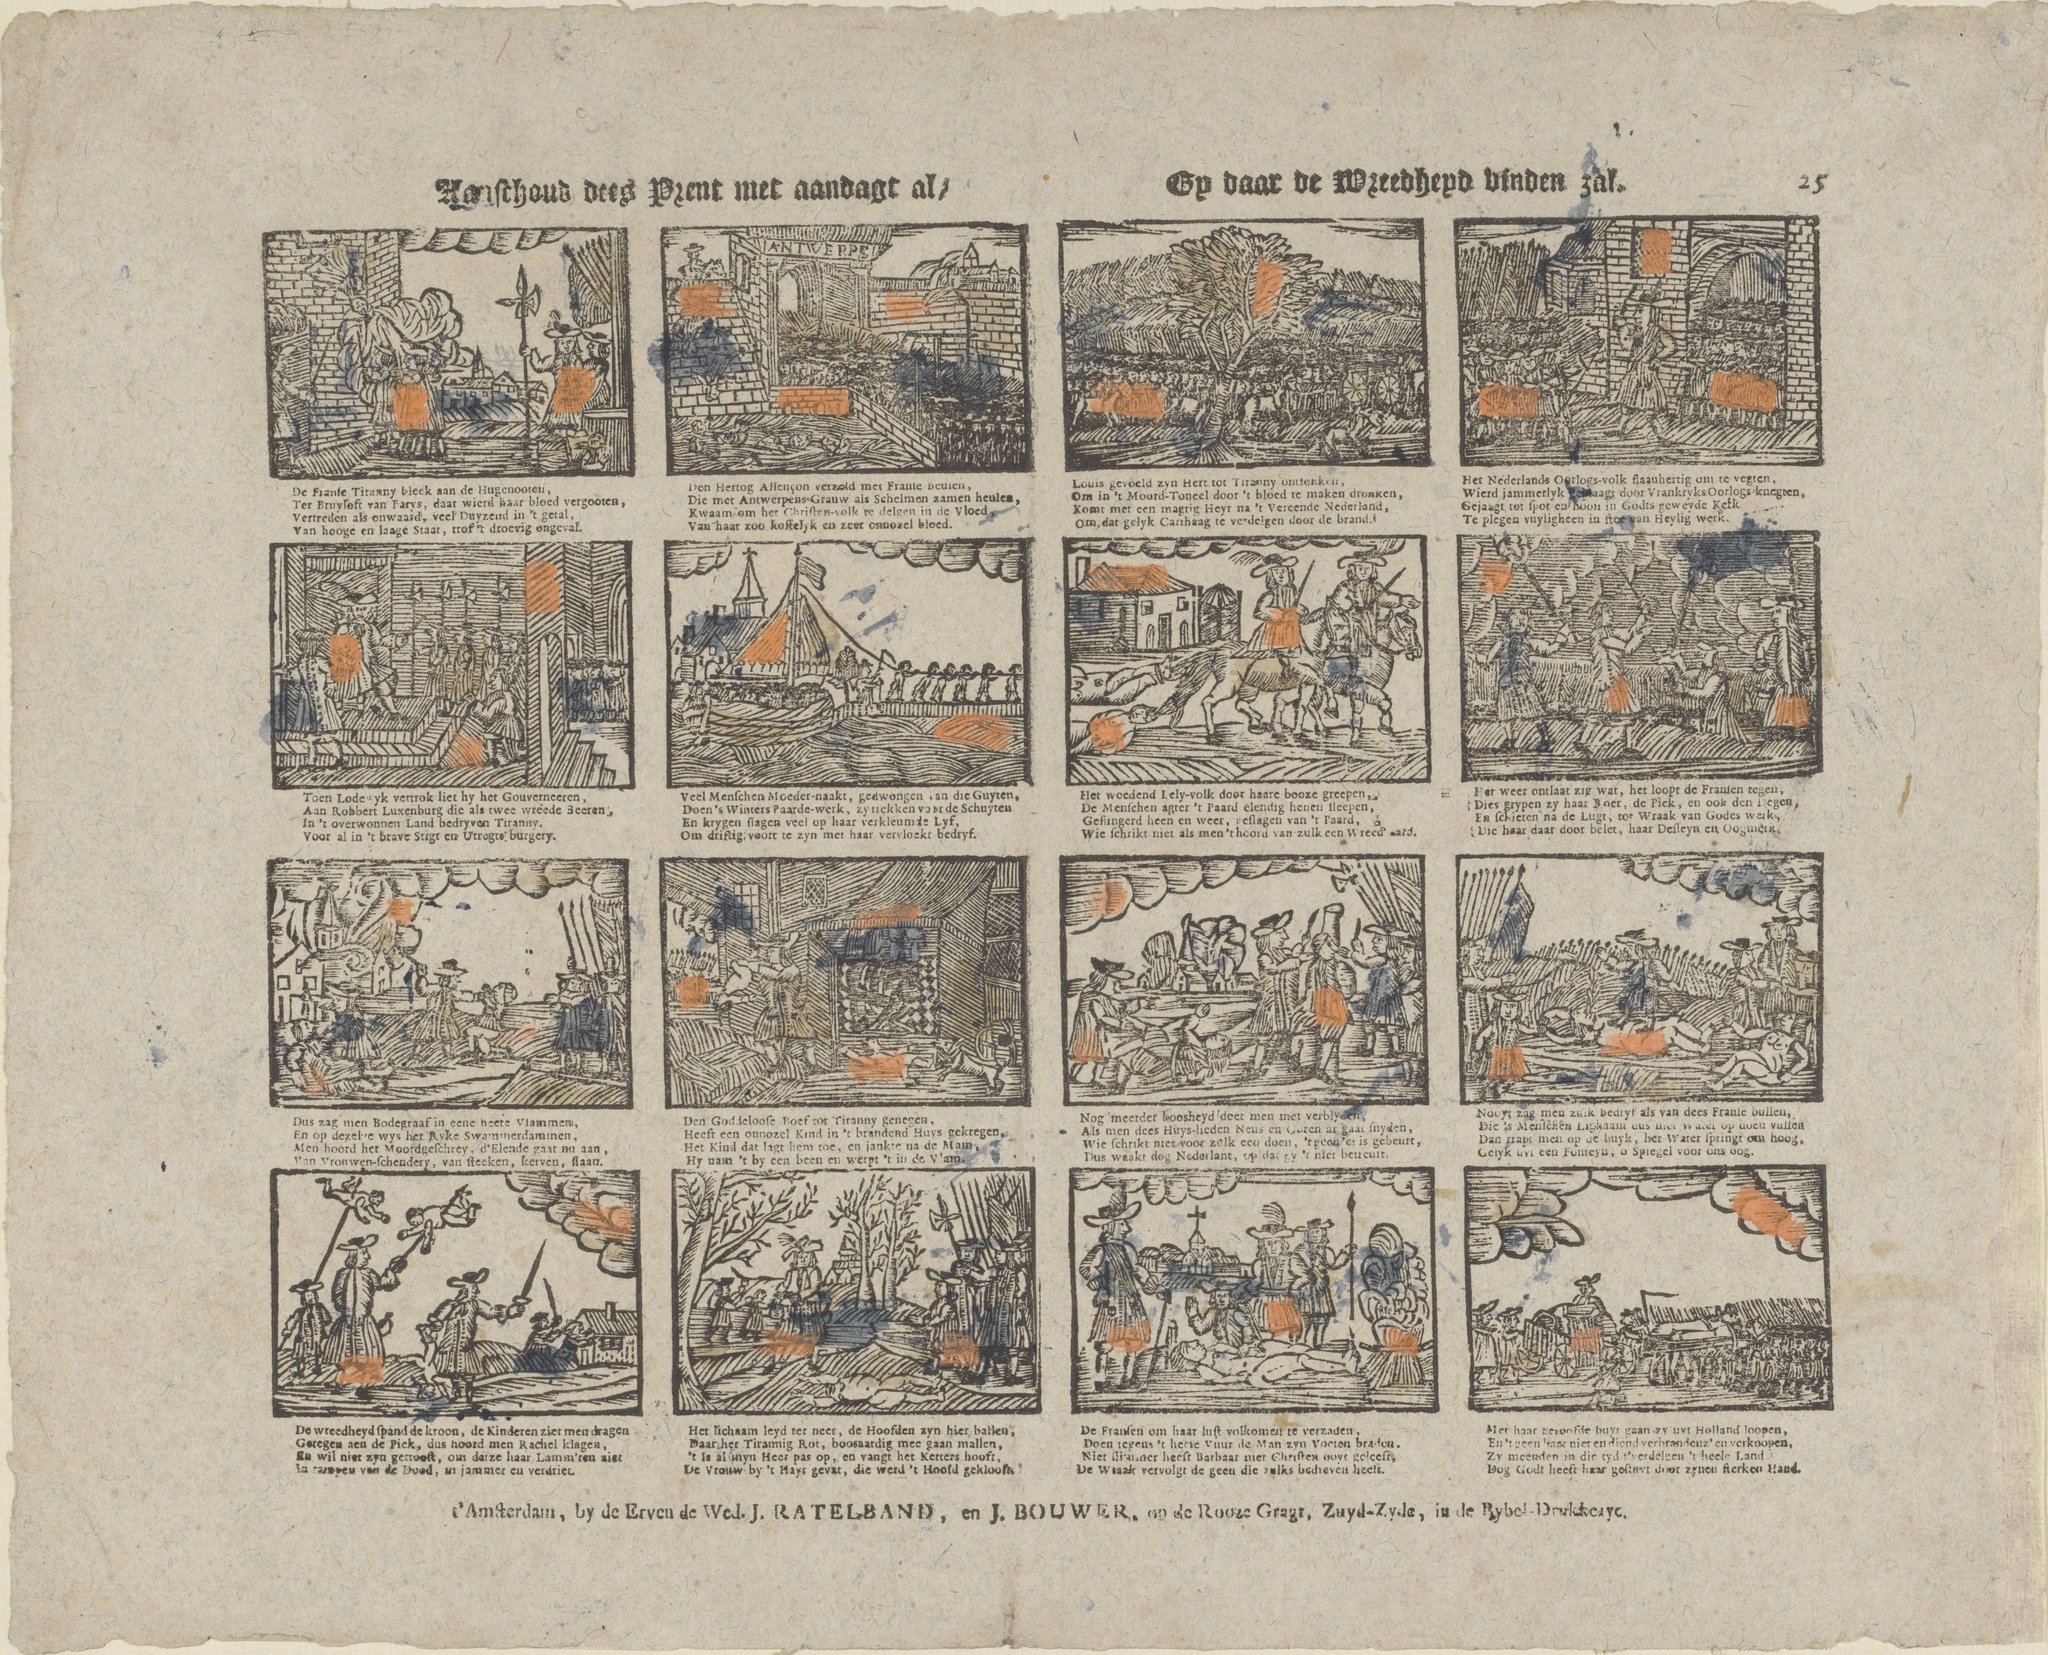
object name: popular print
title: Aanschoud dees prent met aandagt al / Gy daar de wreedheyd vinden zal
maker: Anonymous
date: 1782-1793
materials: paper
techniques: colour, letterpress printing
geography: amsterdam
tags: governmental systems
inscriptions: collector's mark: Lugt 2760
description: Blad met 16 voorstellingen van de Franse tyrannie. Onder elke voorstelling een vierregelig vers. Genummerd rechtsboven: 25.